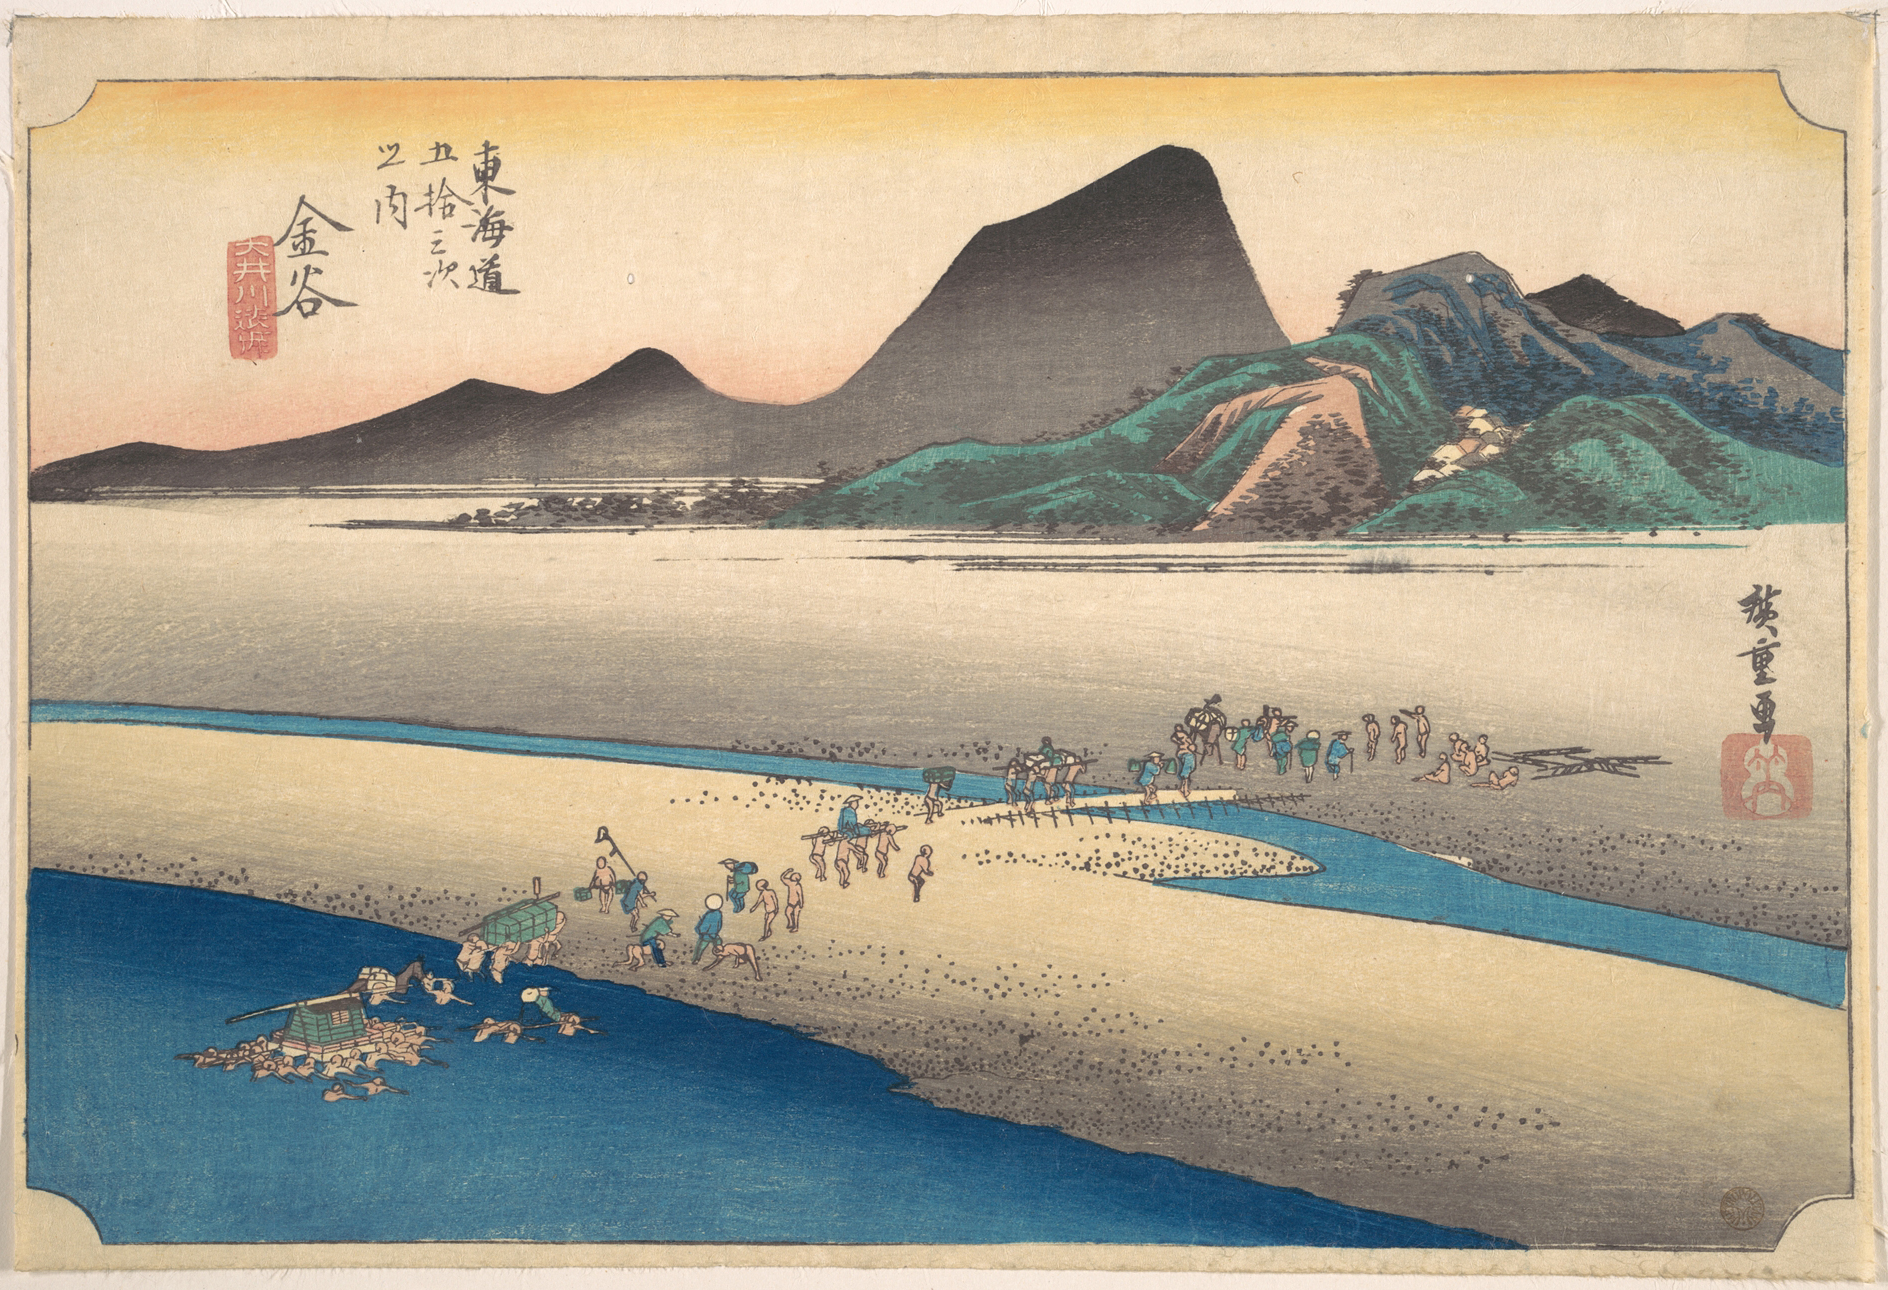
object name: print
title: Kanaya, Oigawa Em Gan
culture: japanese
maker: utagawa hiroshige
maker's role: artist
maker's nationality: japanese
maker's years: 1797-1858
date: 1834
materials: ink, paper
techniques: woodblock print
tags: human figures,rivers,hills,landscapes